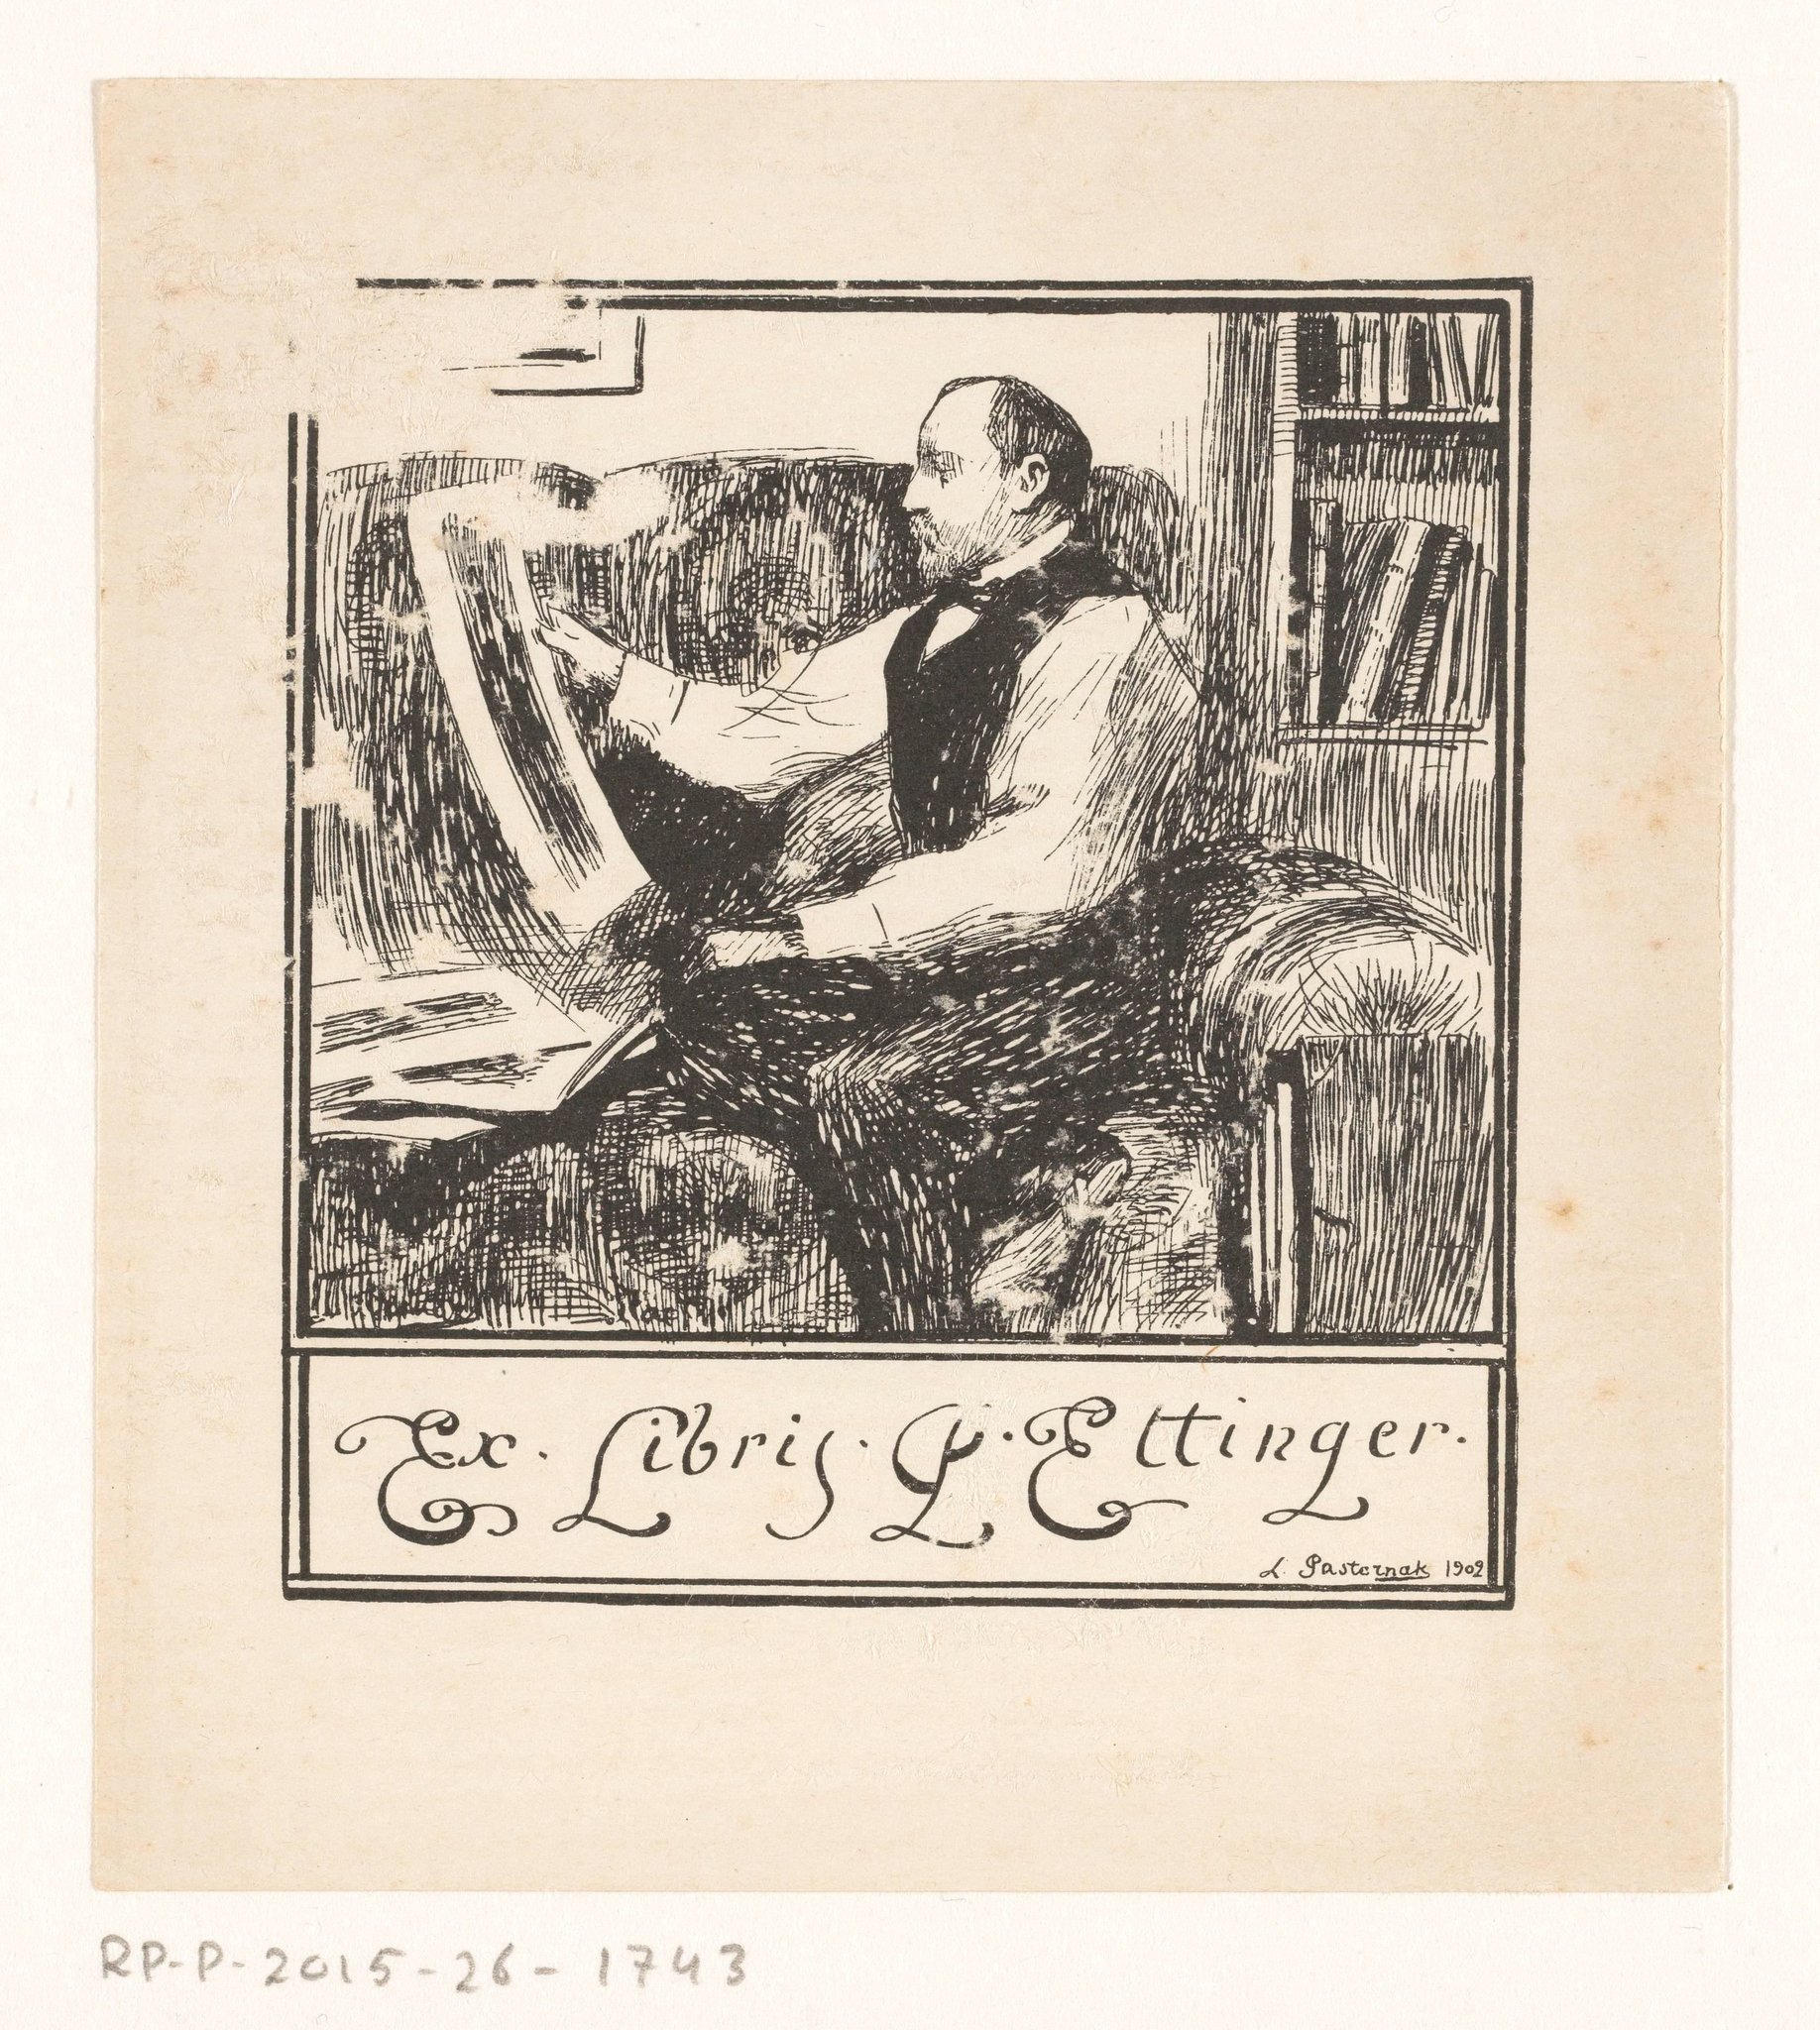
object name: print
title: Ex libris van Pawel Ettinger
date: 1902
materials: paper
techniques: lithograph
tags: bookshelves, print, e.g.: engraving, etching, lithograph, art collector (+ graphic arts)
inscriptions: collector's mark: Lugt 2228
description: Portret van de Pools-Russische verzamelaar Pawel Ettinger, prenten bekijkend op een bank. Naast de bank een boekenkast.